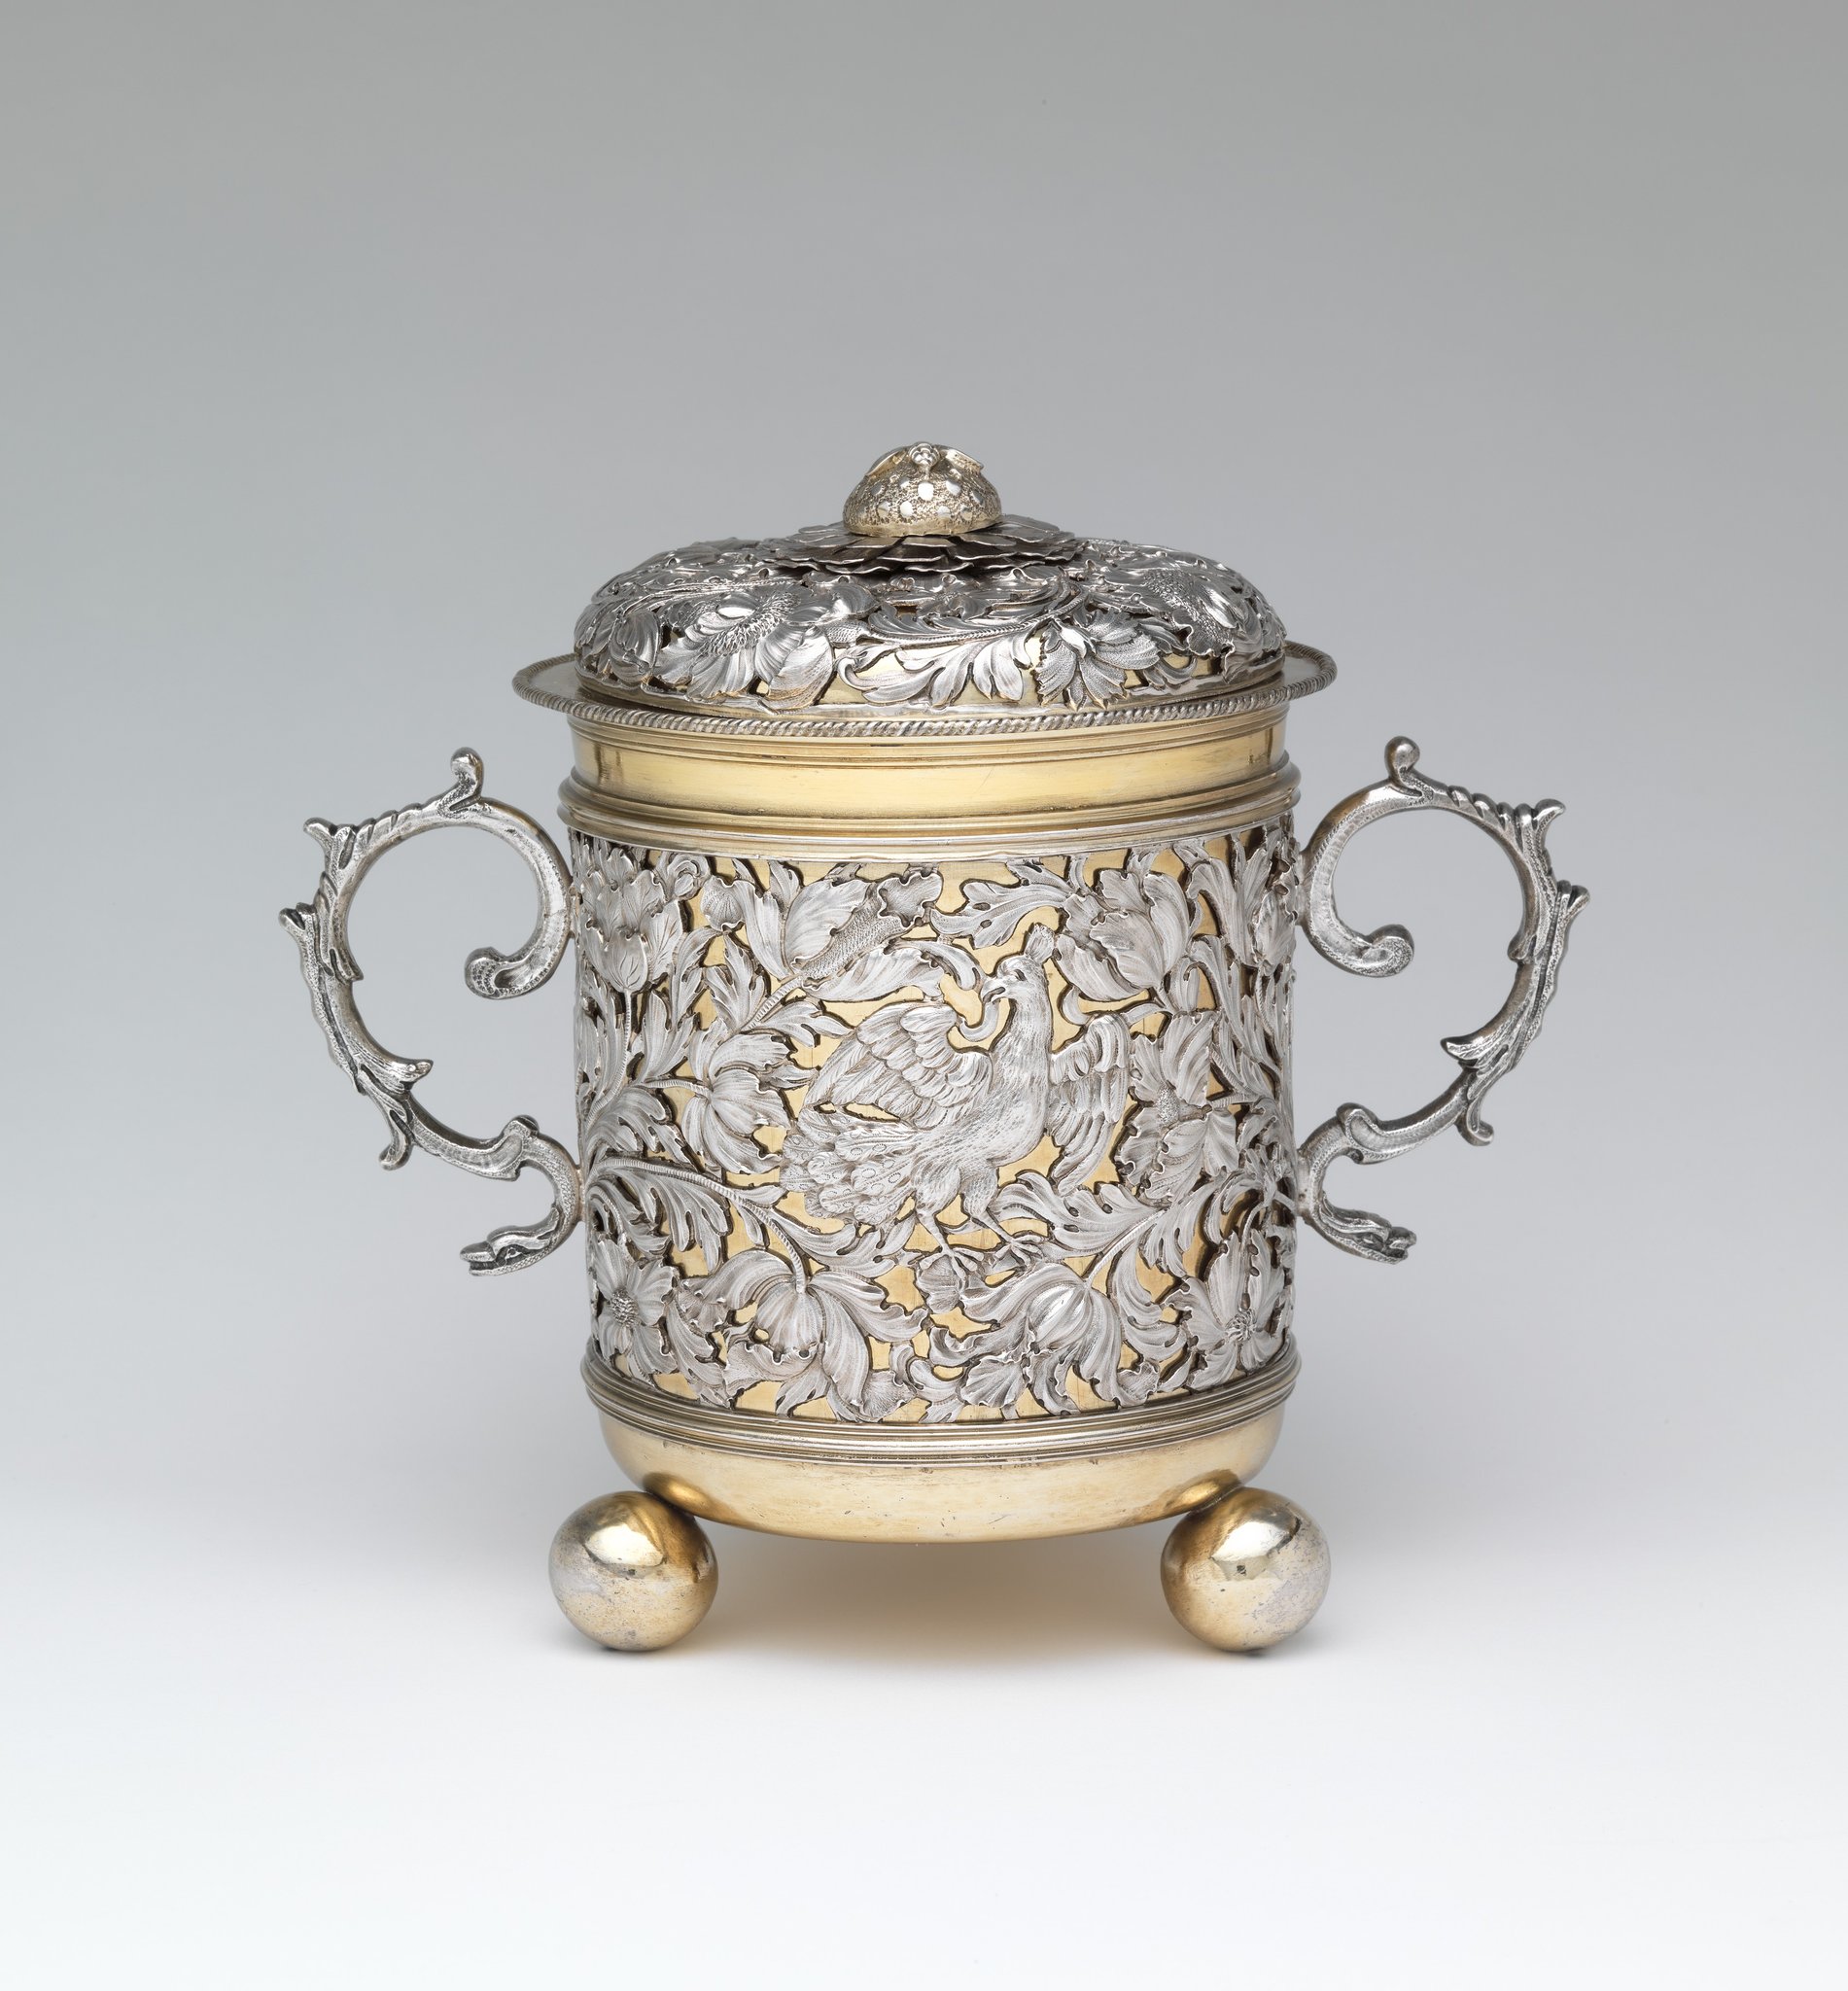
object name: cup with cover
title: Cup with two handles and cover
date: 1680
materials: gilt silver, silver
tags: birds,bees,flowers